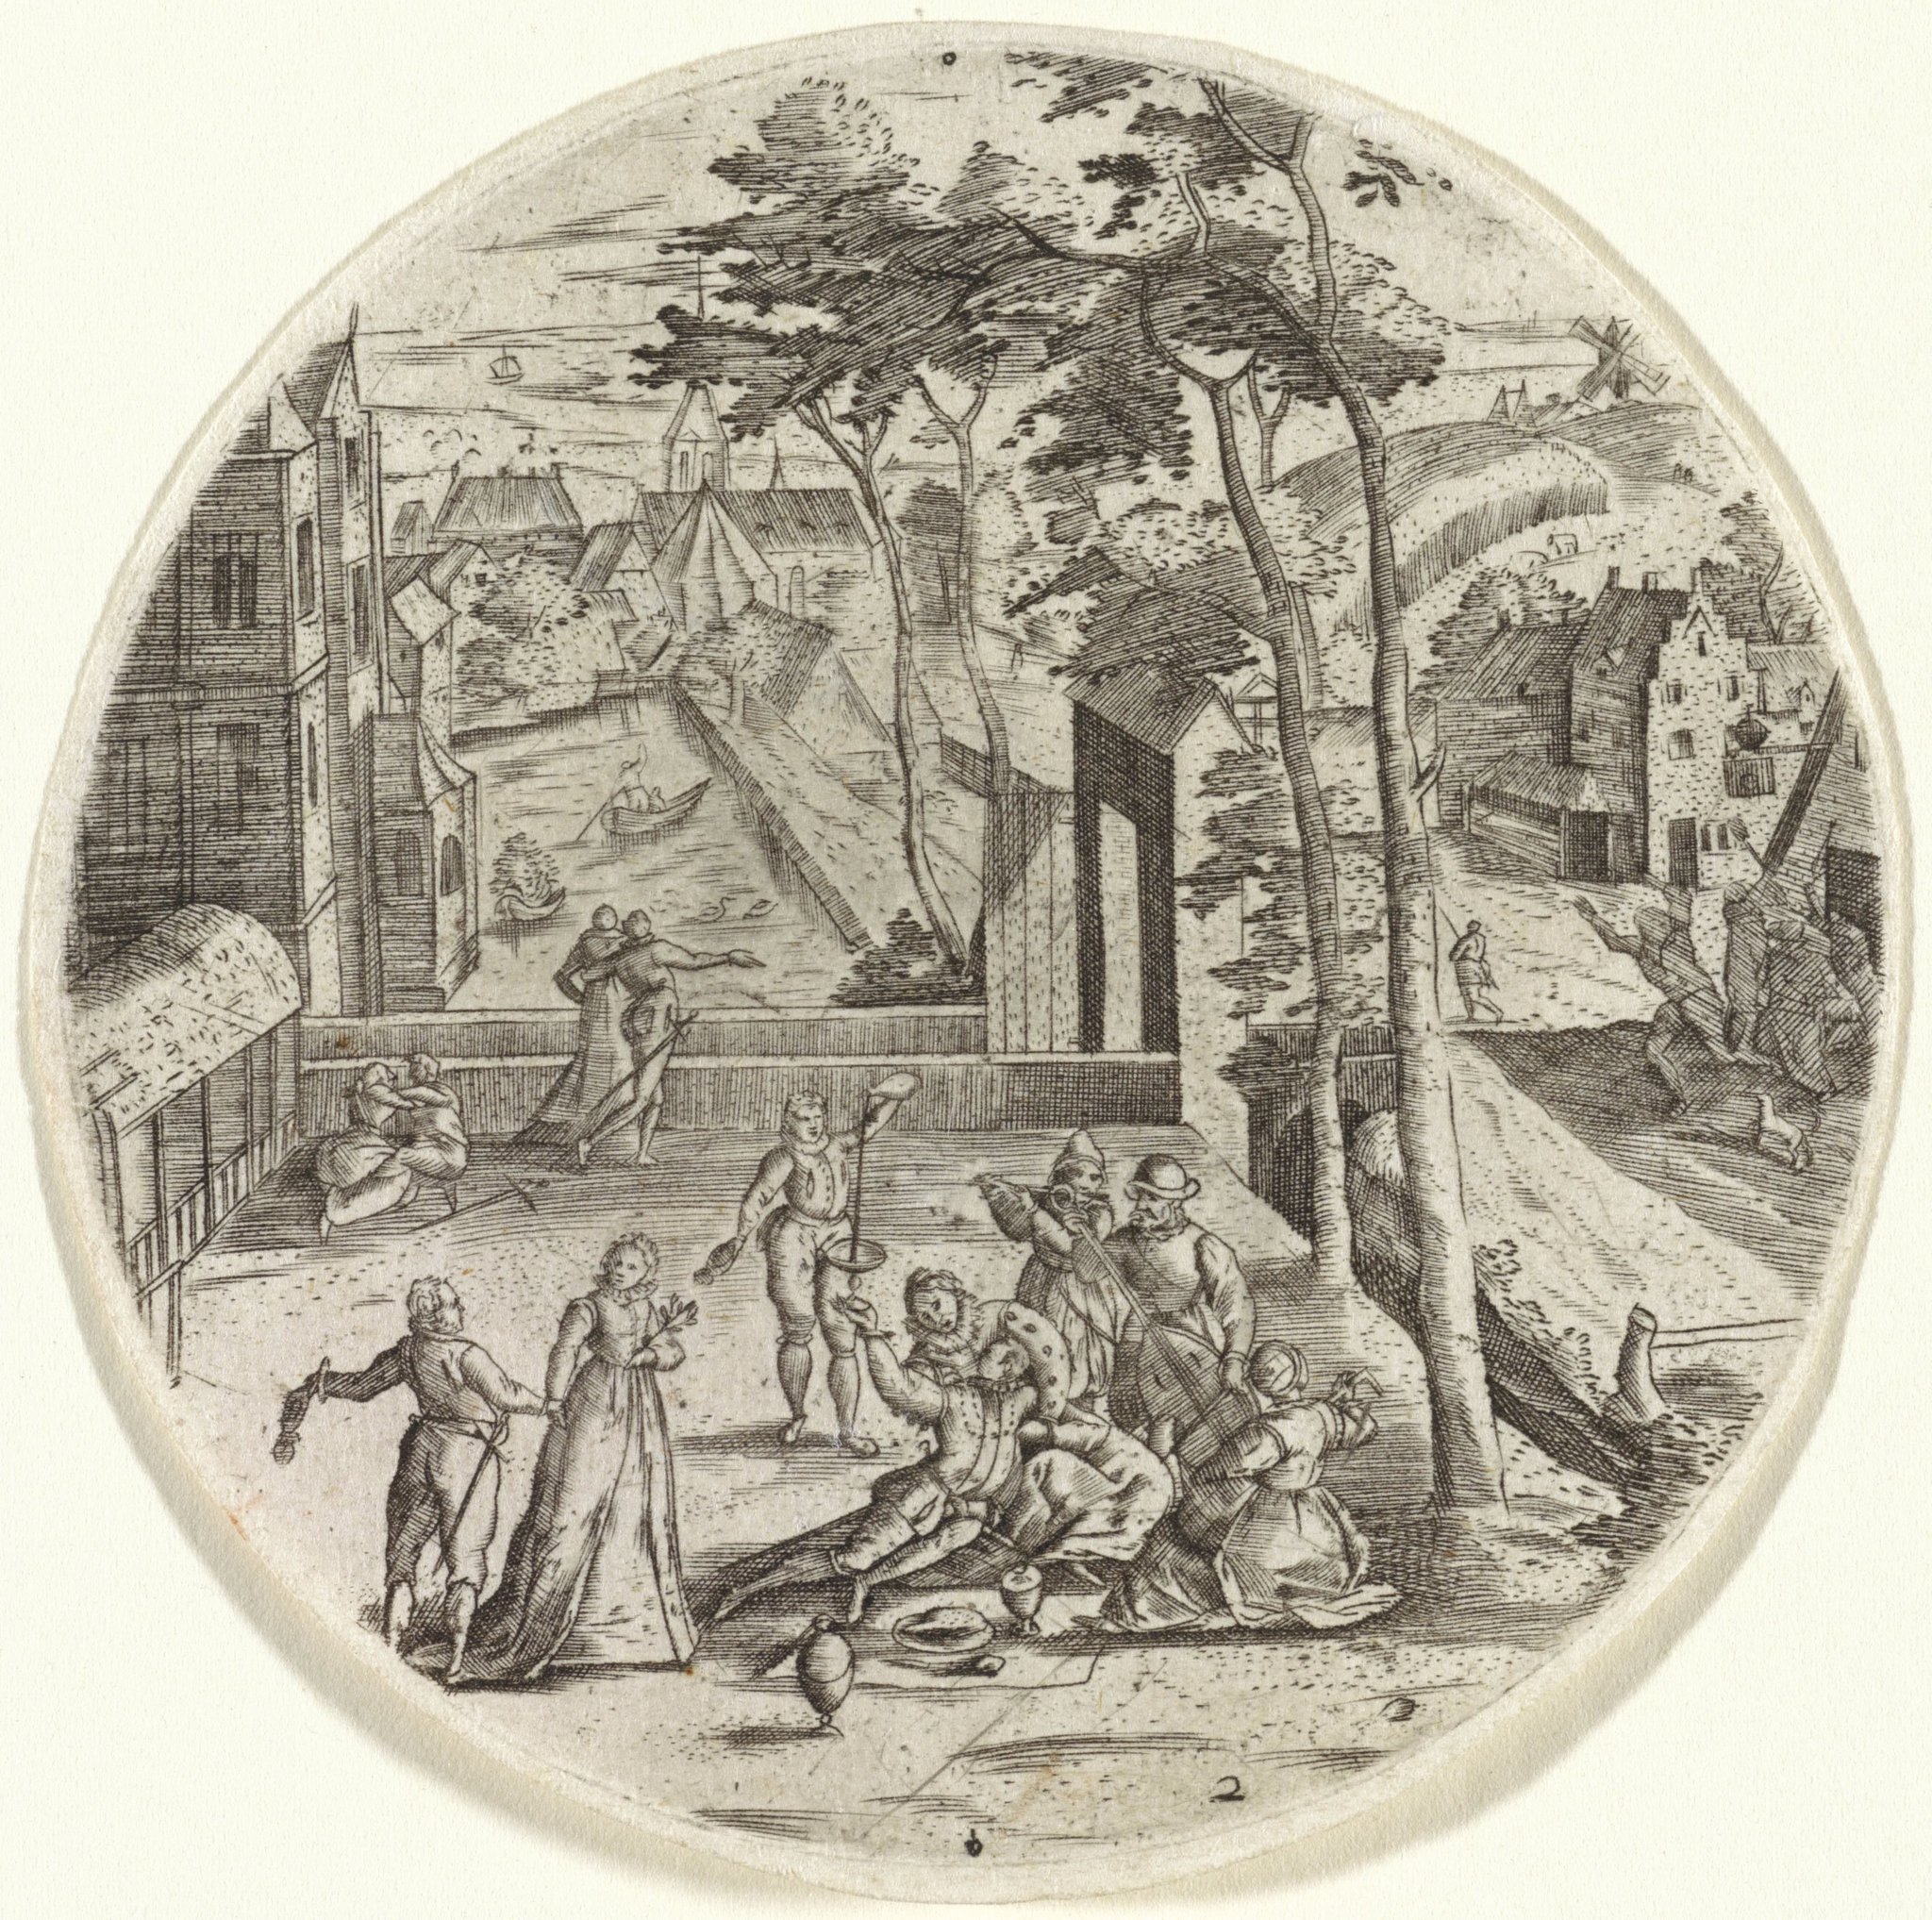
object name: print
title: Verloren zoon verkwist zijn geld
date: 1612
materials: paper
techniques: etching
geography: low countries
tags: the prodigal son in the midst of prostitutes feasting and dissipating his patrimony, usually in a brothel or inn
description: Op een voorplein voor een kasteel ligt de verloren zoon in de armen van een prostituee, terwijl een bediende zijn wijn bijvult. Twee muzikanten en een dame die een luit bespeelt, maken deel uit van het gezelschap. Rechtsachter wordt de verloren zoon een huis uitgejaagd.